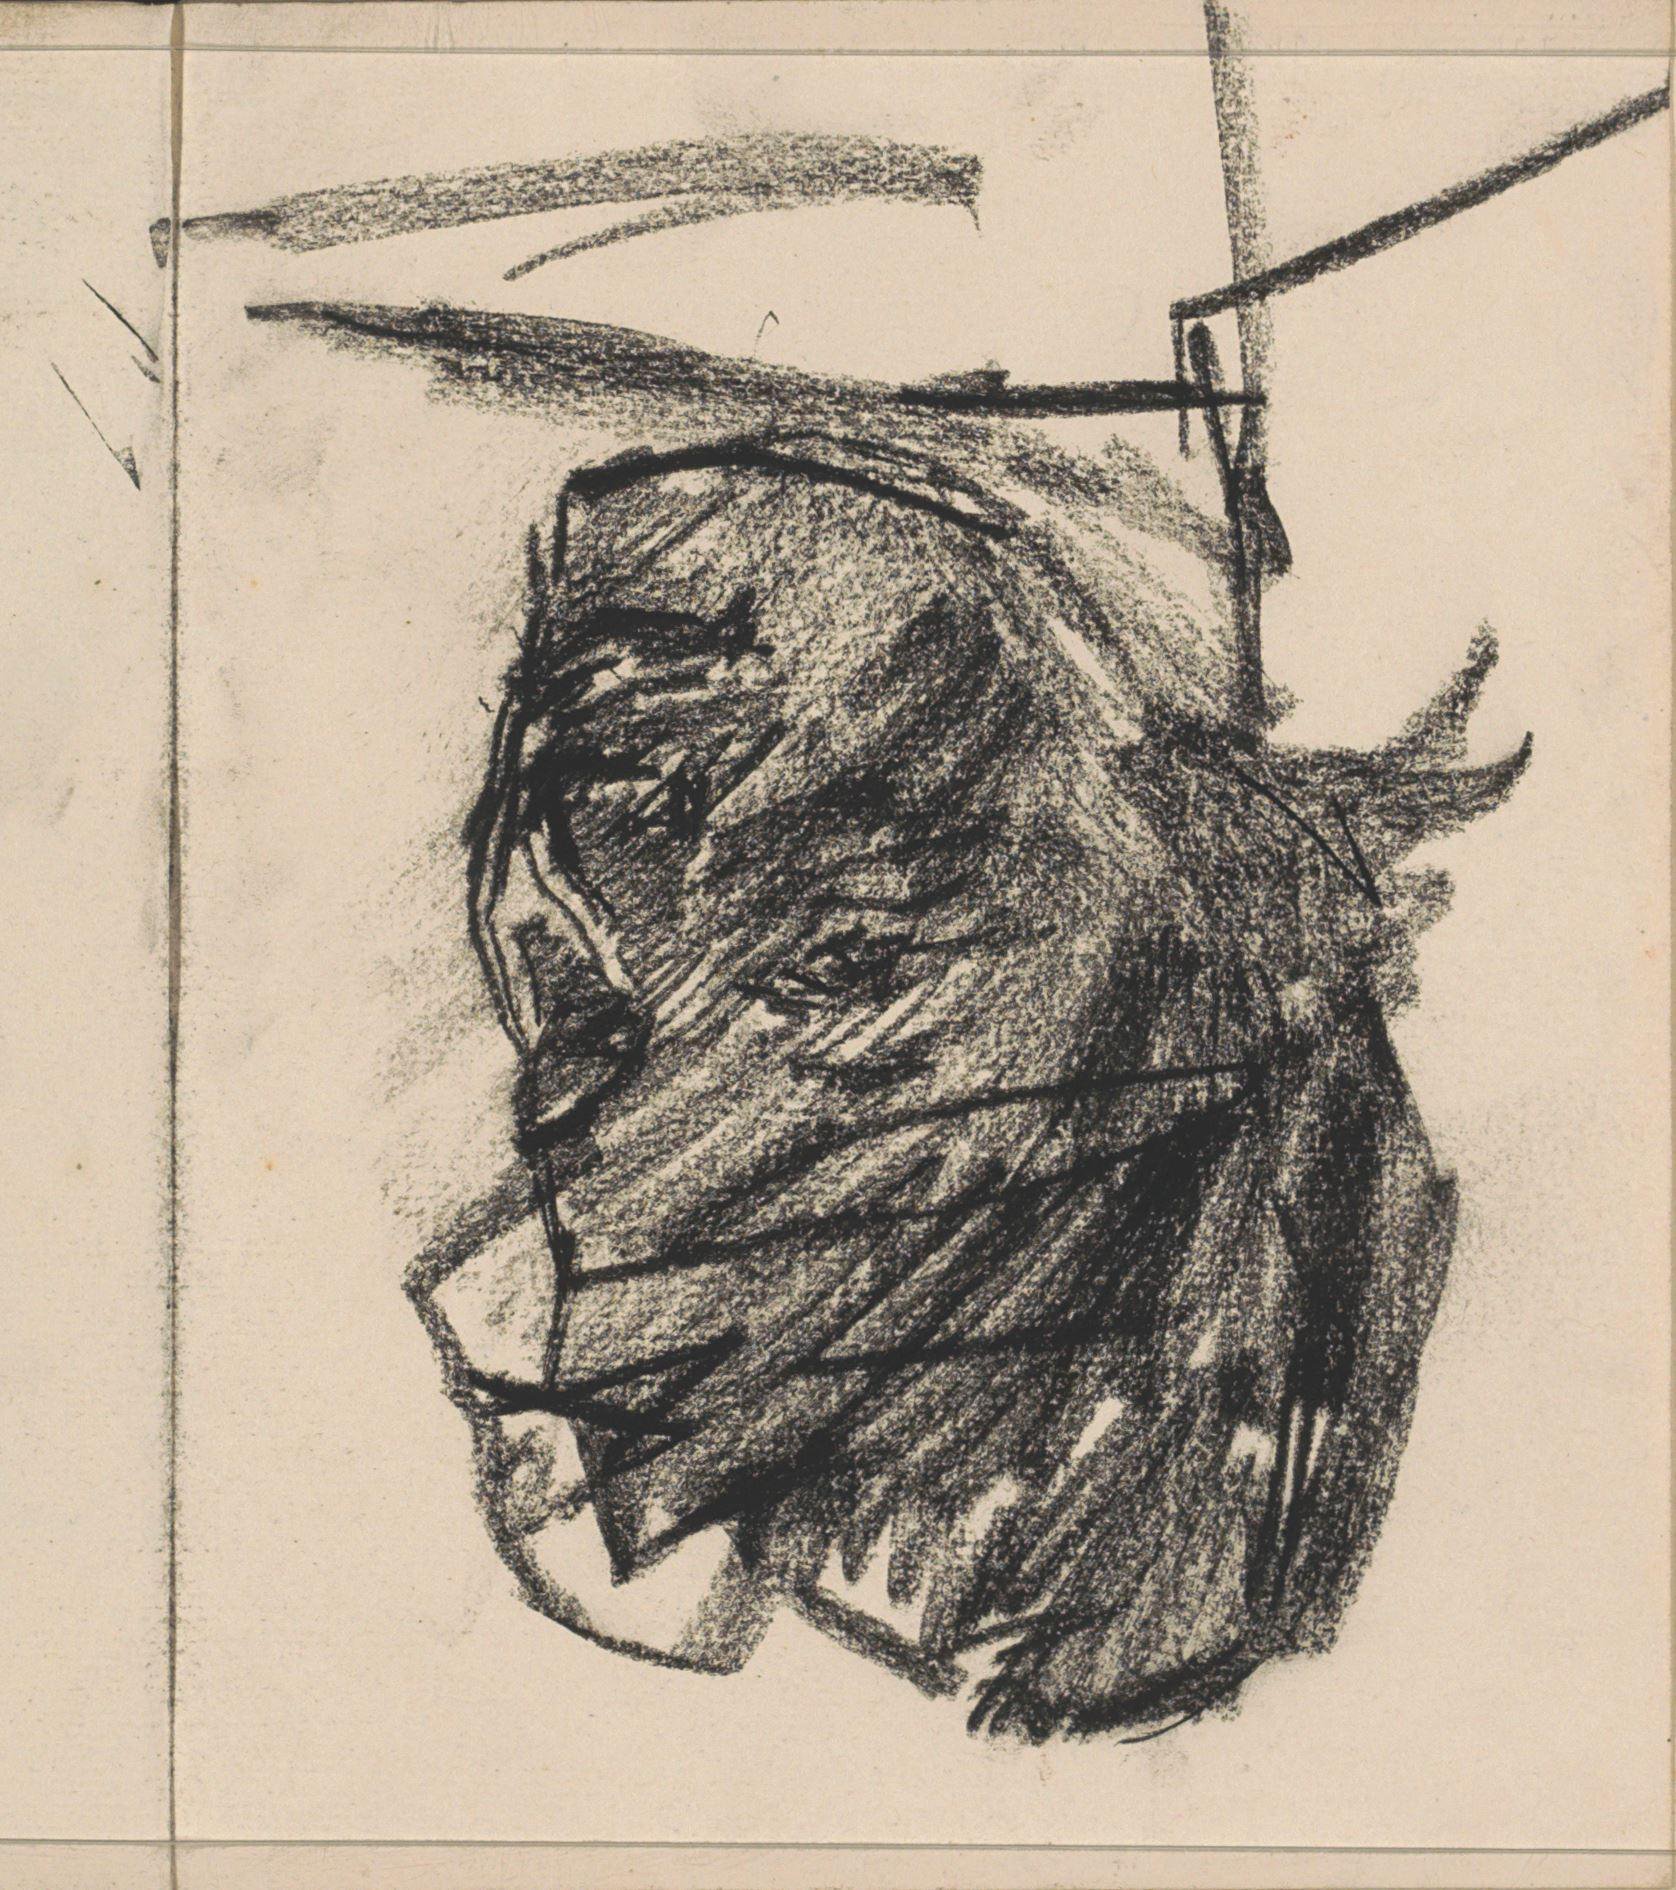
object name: sketchbook leaf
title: Vrouwenhoofd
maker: isaac israels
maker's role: draughtsman, painter, print maker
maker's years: 1865-1934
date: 1886-1903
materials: chalk, paper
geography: amsterdam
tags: head (human) - aa - female human figure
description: Pagina 33 uit schetsboek XXXII met 92 pagina's.